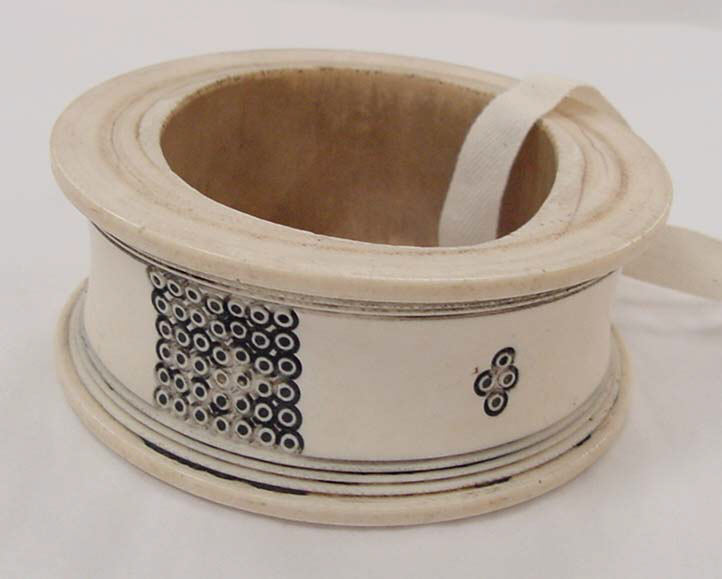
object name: bracelet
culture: african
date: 1867-1900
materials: ivory